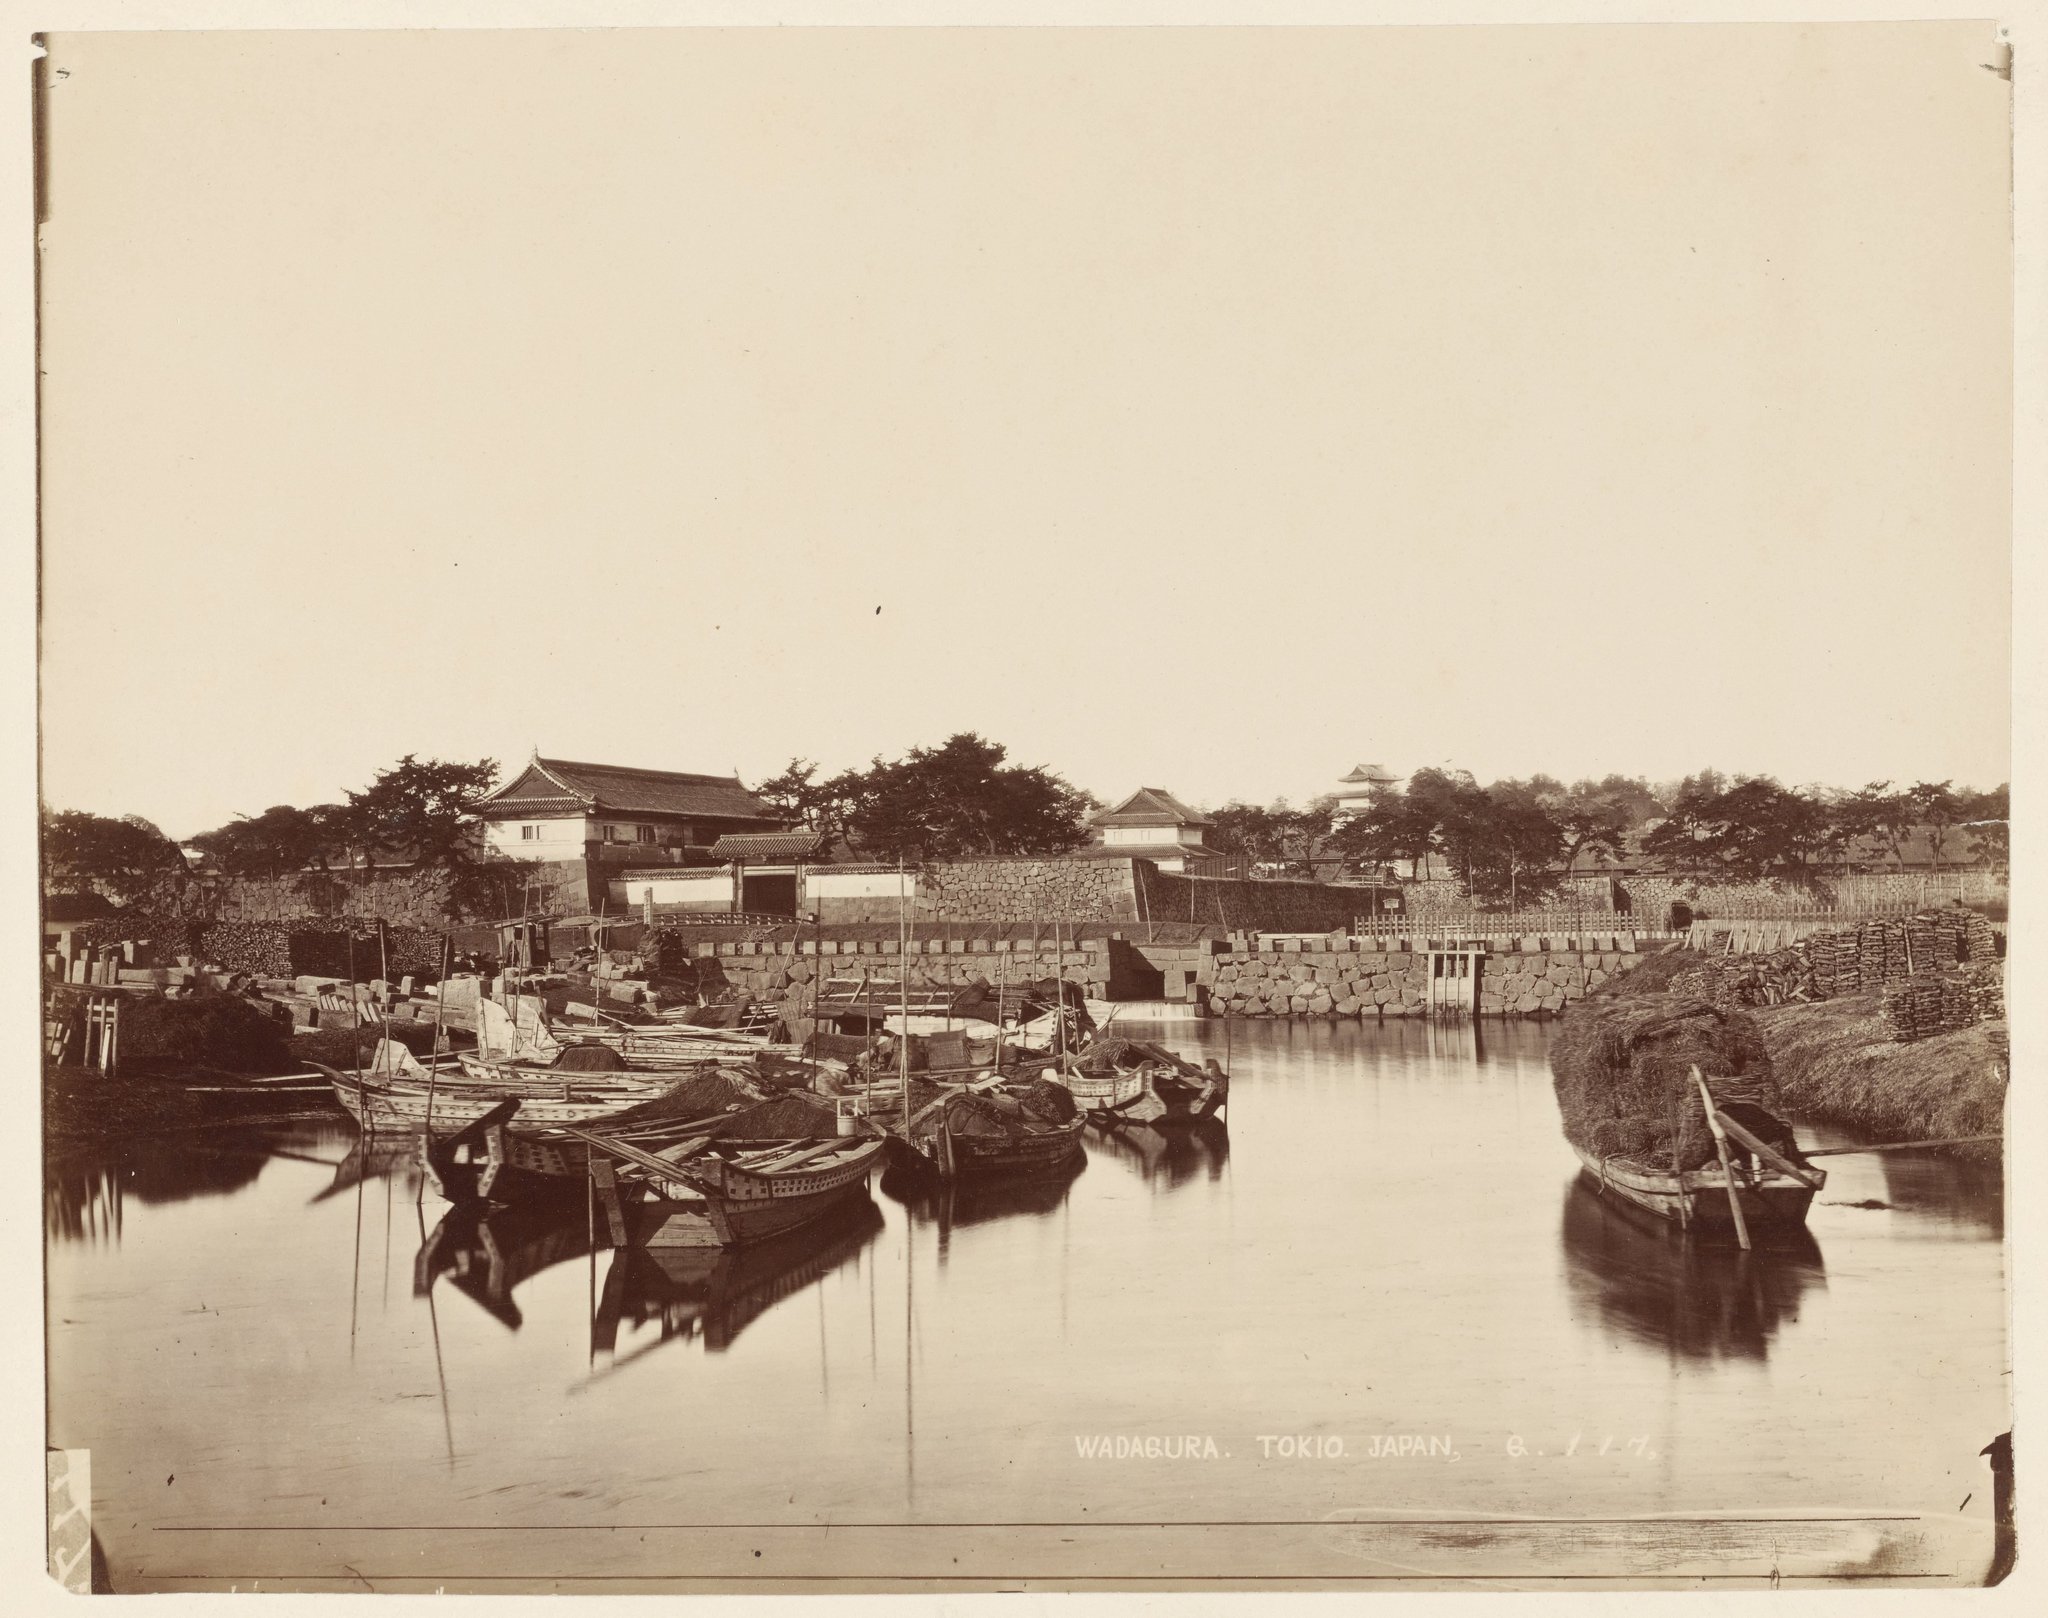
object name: photograph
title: Japan 1884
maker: Anonymous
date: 1884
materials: cardboard, paper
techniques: albumen print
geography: chiyoda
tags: harbour, palace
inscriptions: inscription: ‘G. / / 7, [?]’